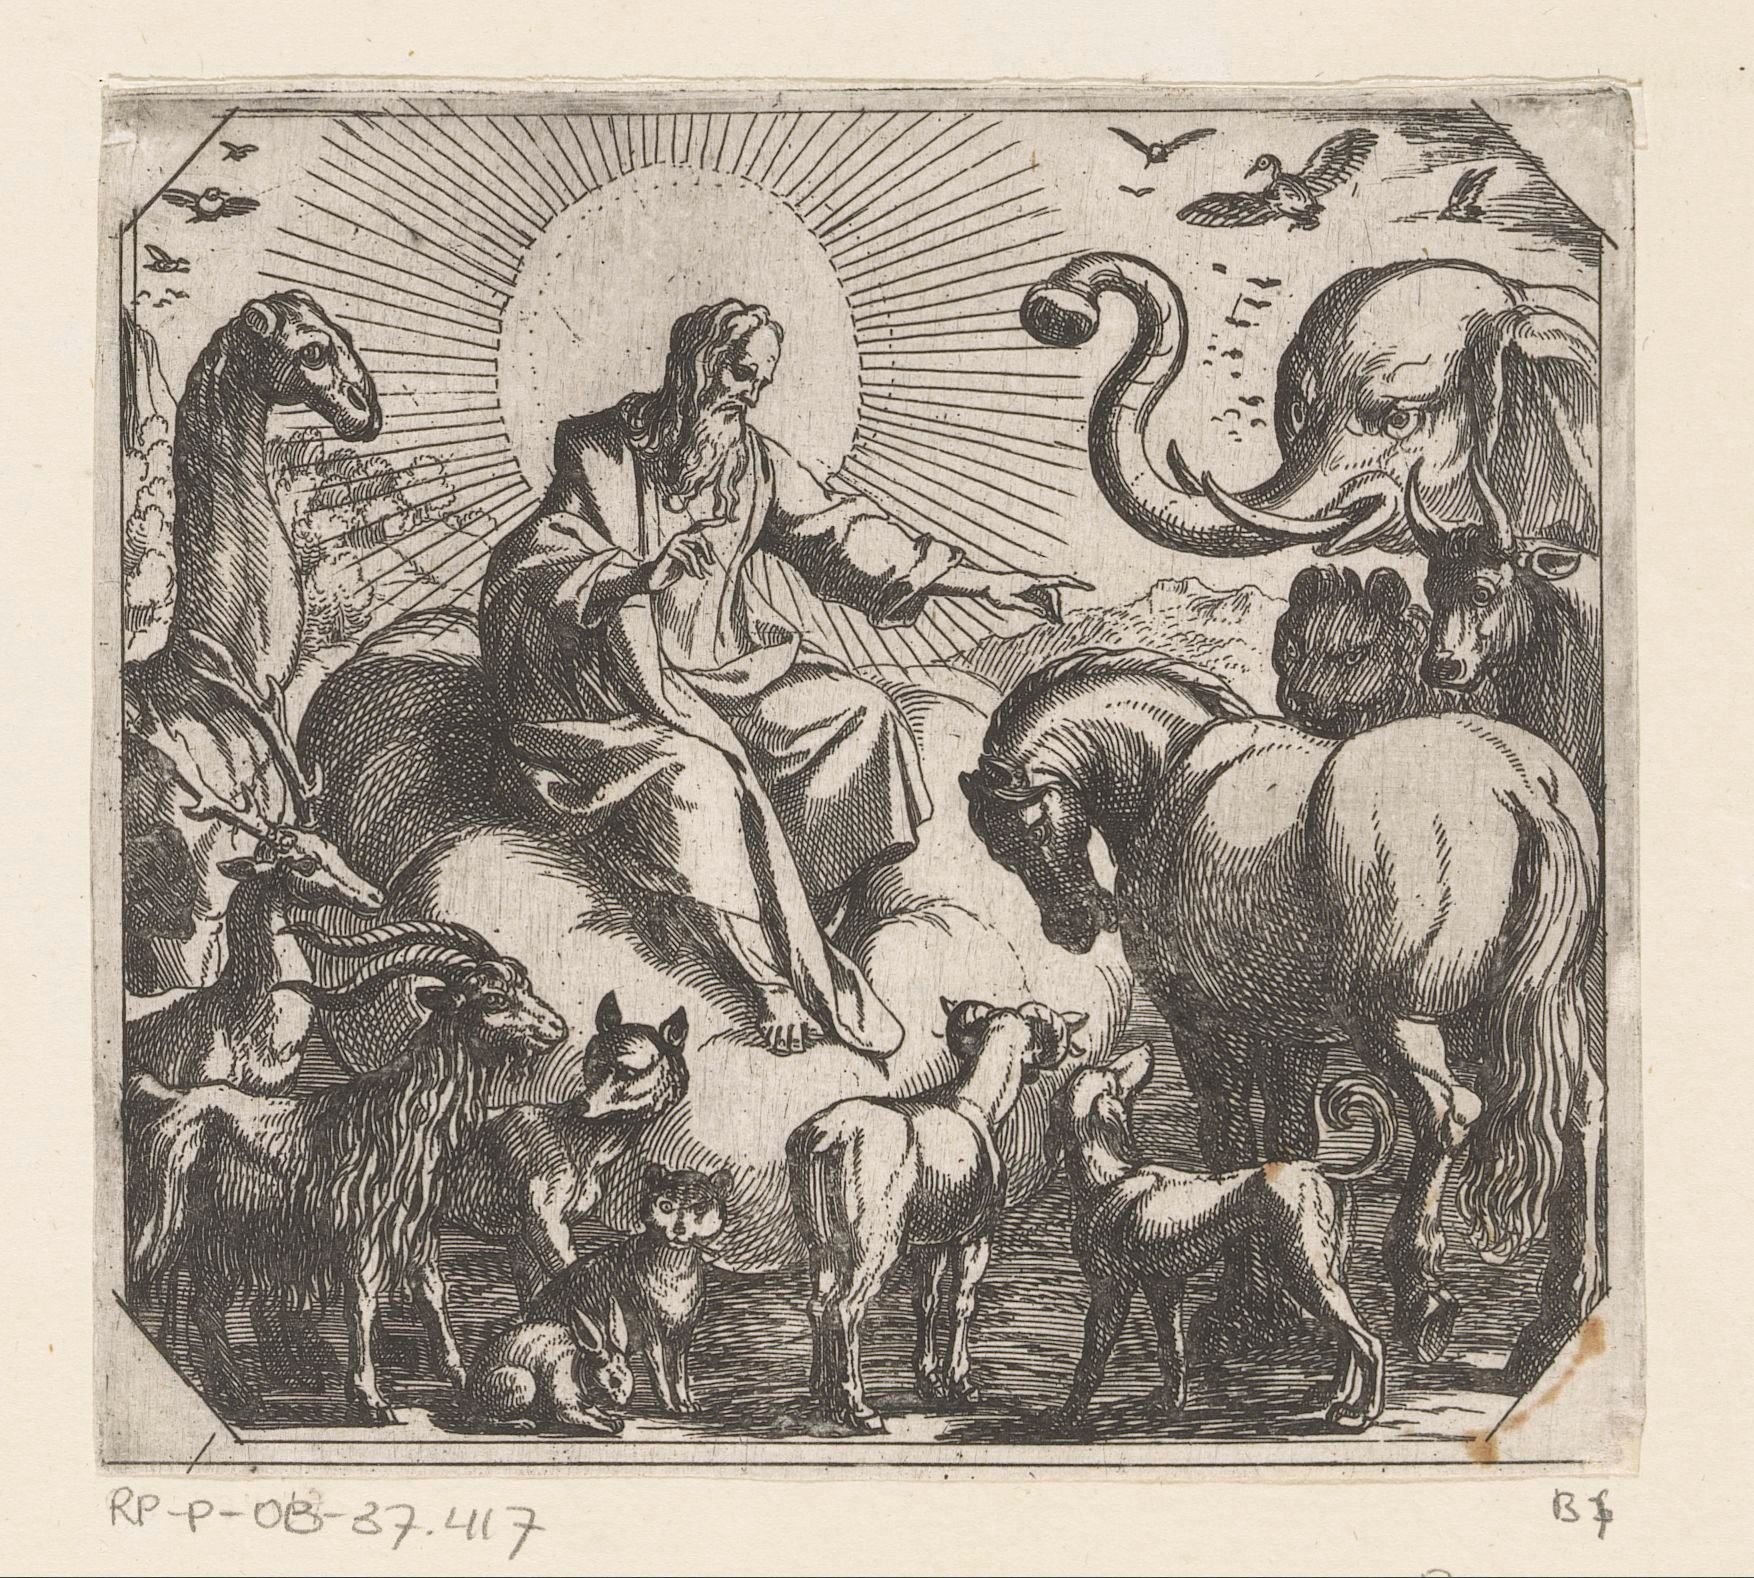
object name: print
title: De schepping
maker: antonio tempesta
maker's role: draughtsman, painter, print maker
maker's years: 1555-1630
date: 1565-1630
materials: paper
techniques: etching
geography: rome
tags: creation of land-animals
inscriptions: collector's mark: Lugt 240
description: Deze prent maakt deel uit van een serie van twaalf prenten van de schepping. De prenten zijn deels naar ontwerpen van Rafaël voor de Loggia van Rafaël in het Vaticaan, en deels naar prenten door Nicolaes de Bruyn naar ontwerpen van Maerten de Vos (zie: Holl. Dutch. vol. 45 nr. 1-10).